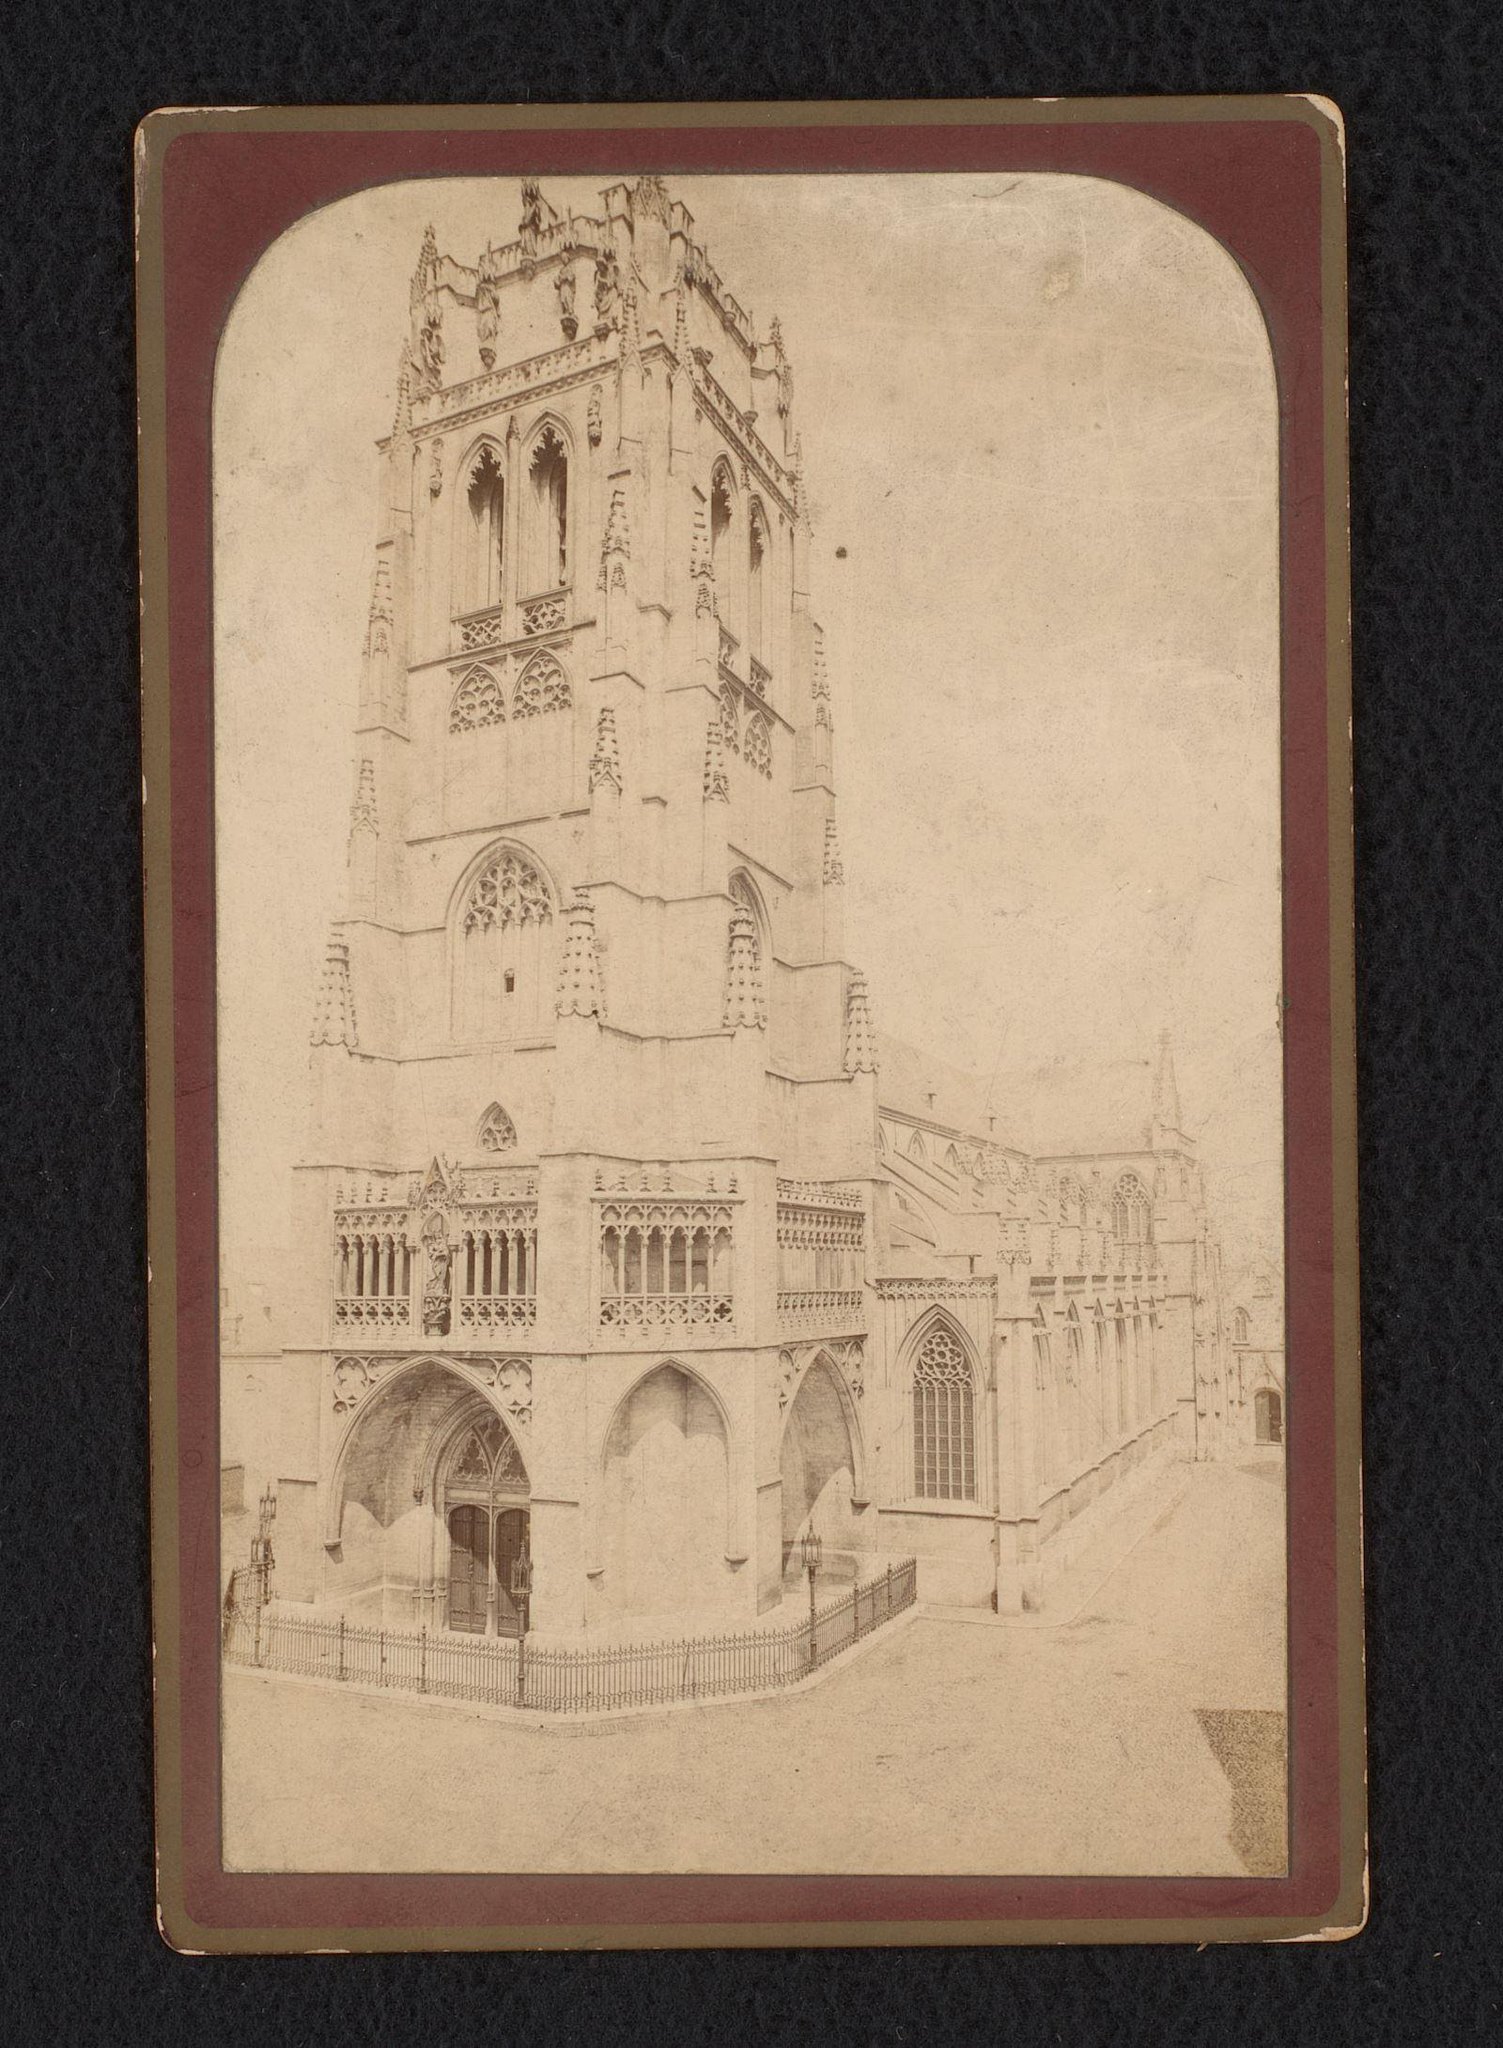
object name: cabinet photograph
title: Exterieur van een gothische kerk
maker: Anonymous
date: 1880-1900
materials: paper, cardboard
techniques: gelatin silver print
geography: france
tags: church (exterior), france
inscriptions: number: ‘0.45’, inscription: ‘ubi’